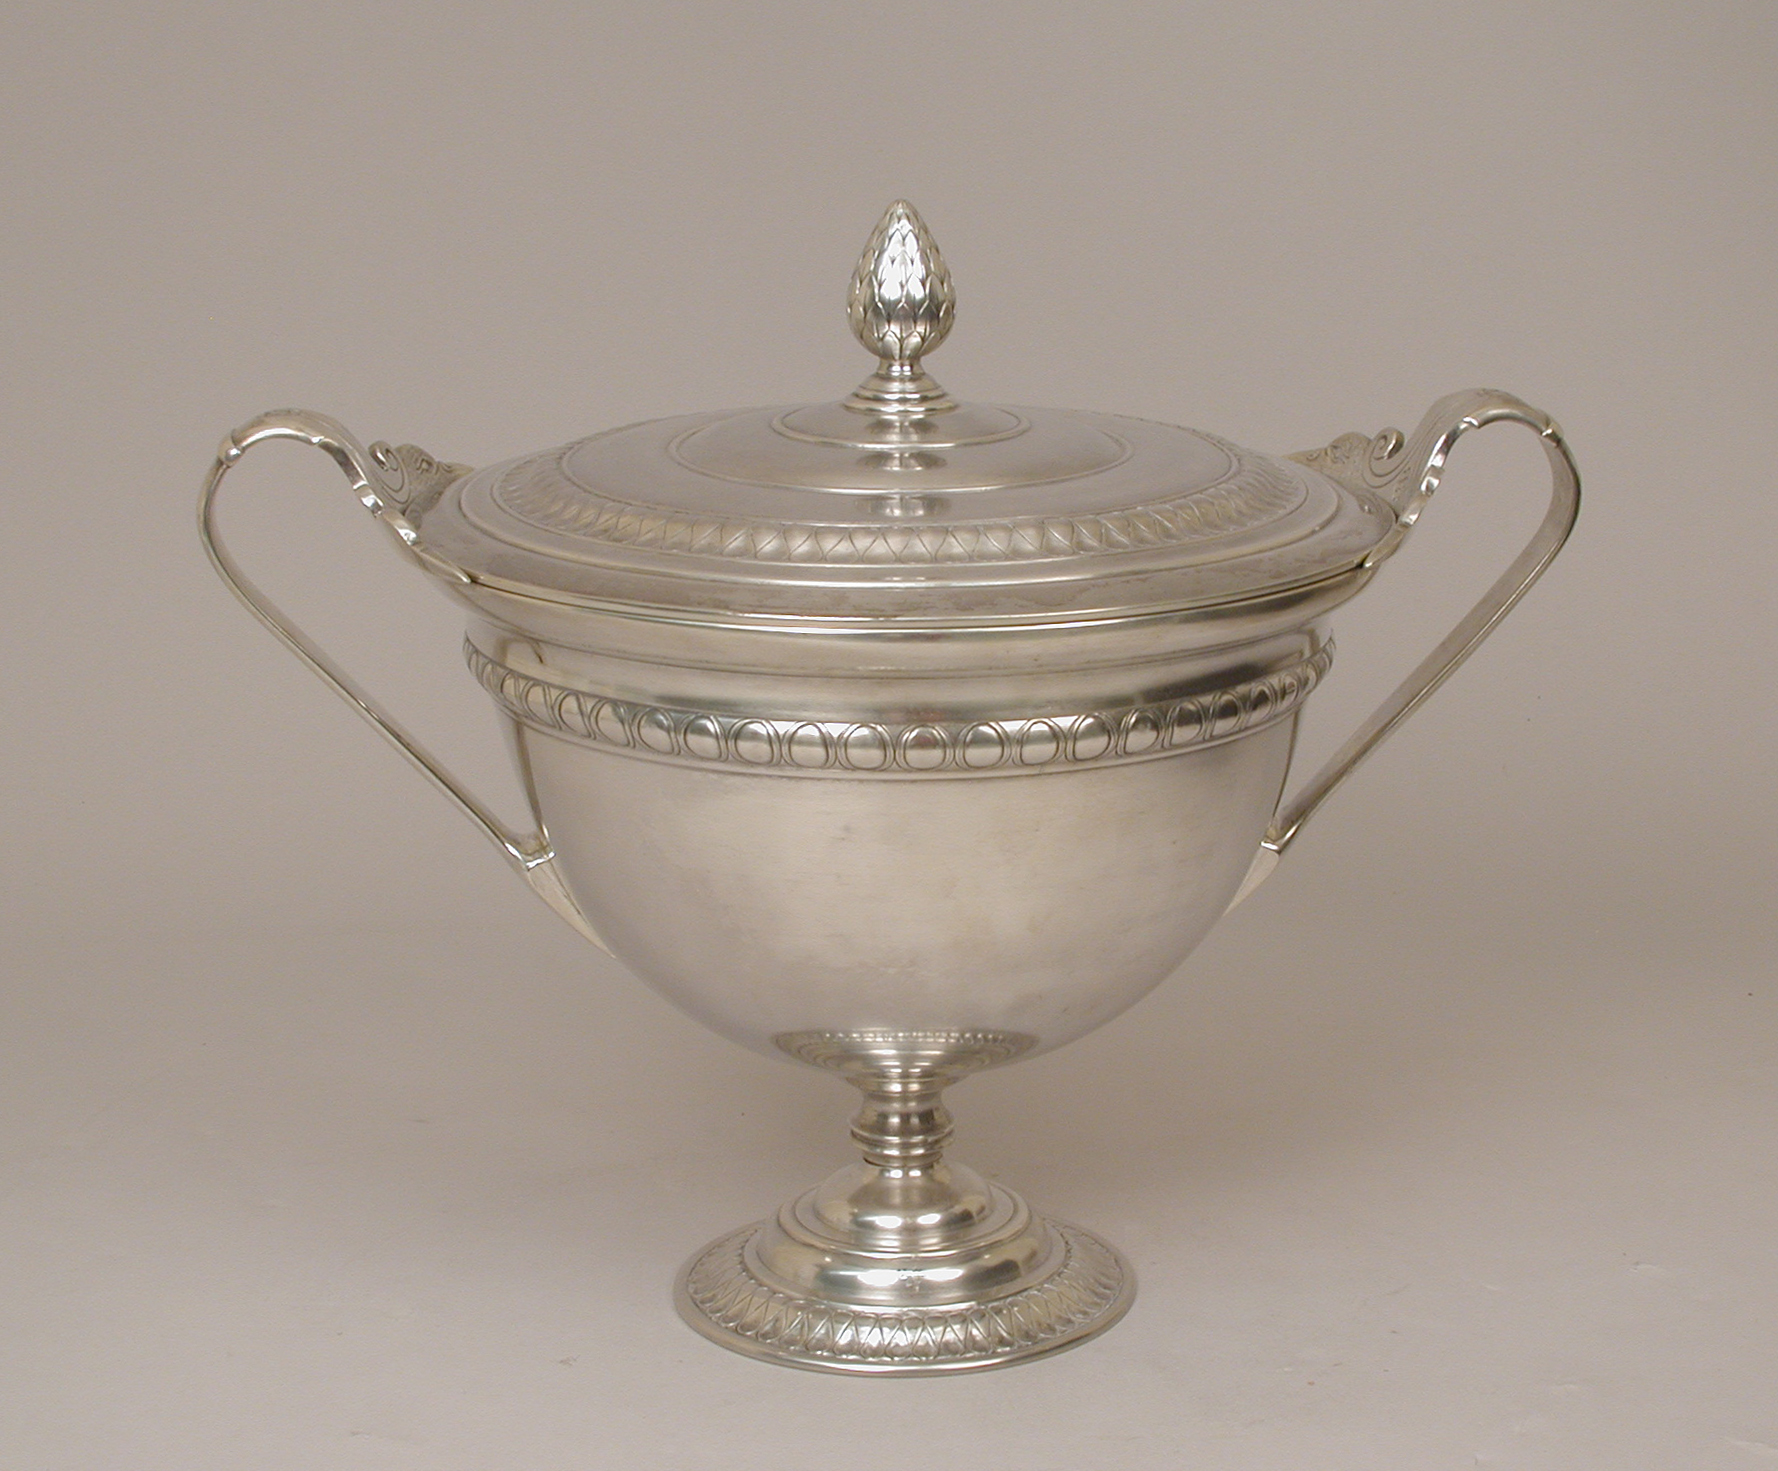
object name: bowl with cover, ladle and tray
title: Covered bowl with ladle and tray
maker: giacinto melillo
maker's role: maker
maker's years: 1846-1915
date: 1900-1910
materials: silver